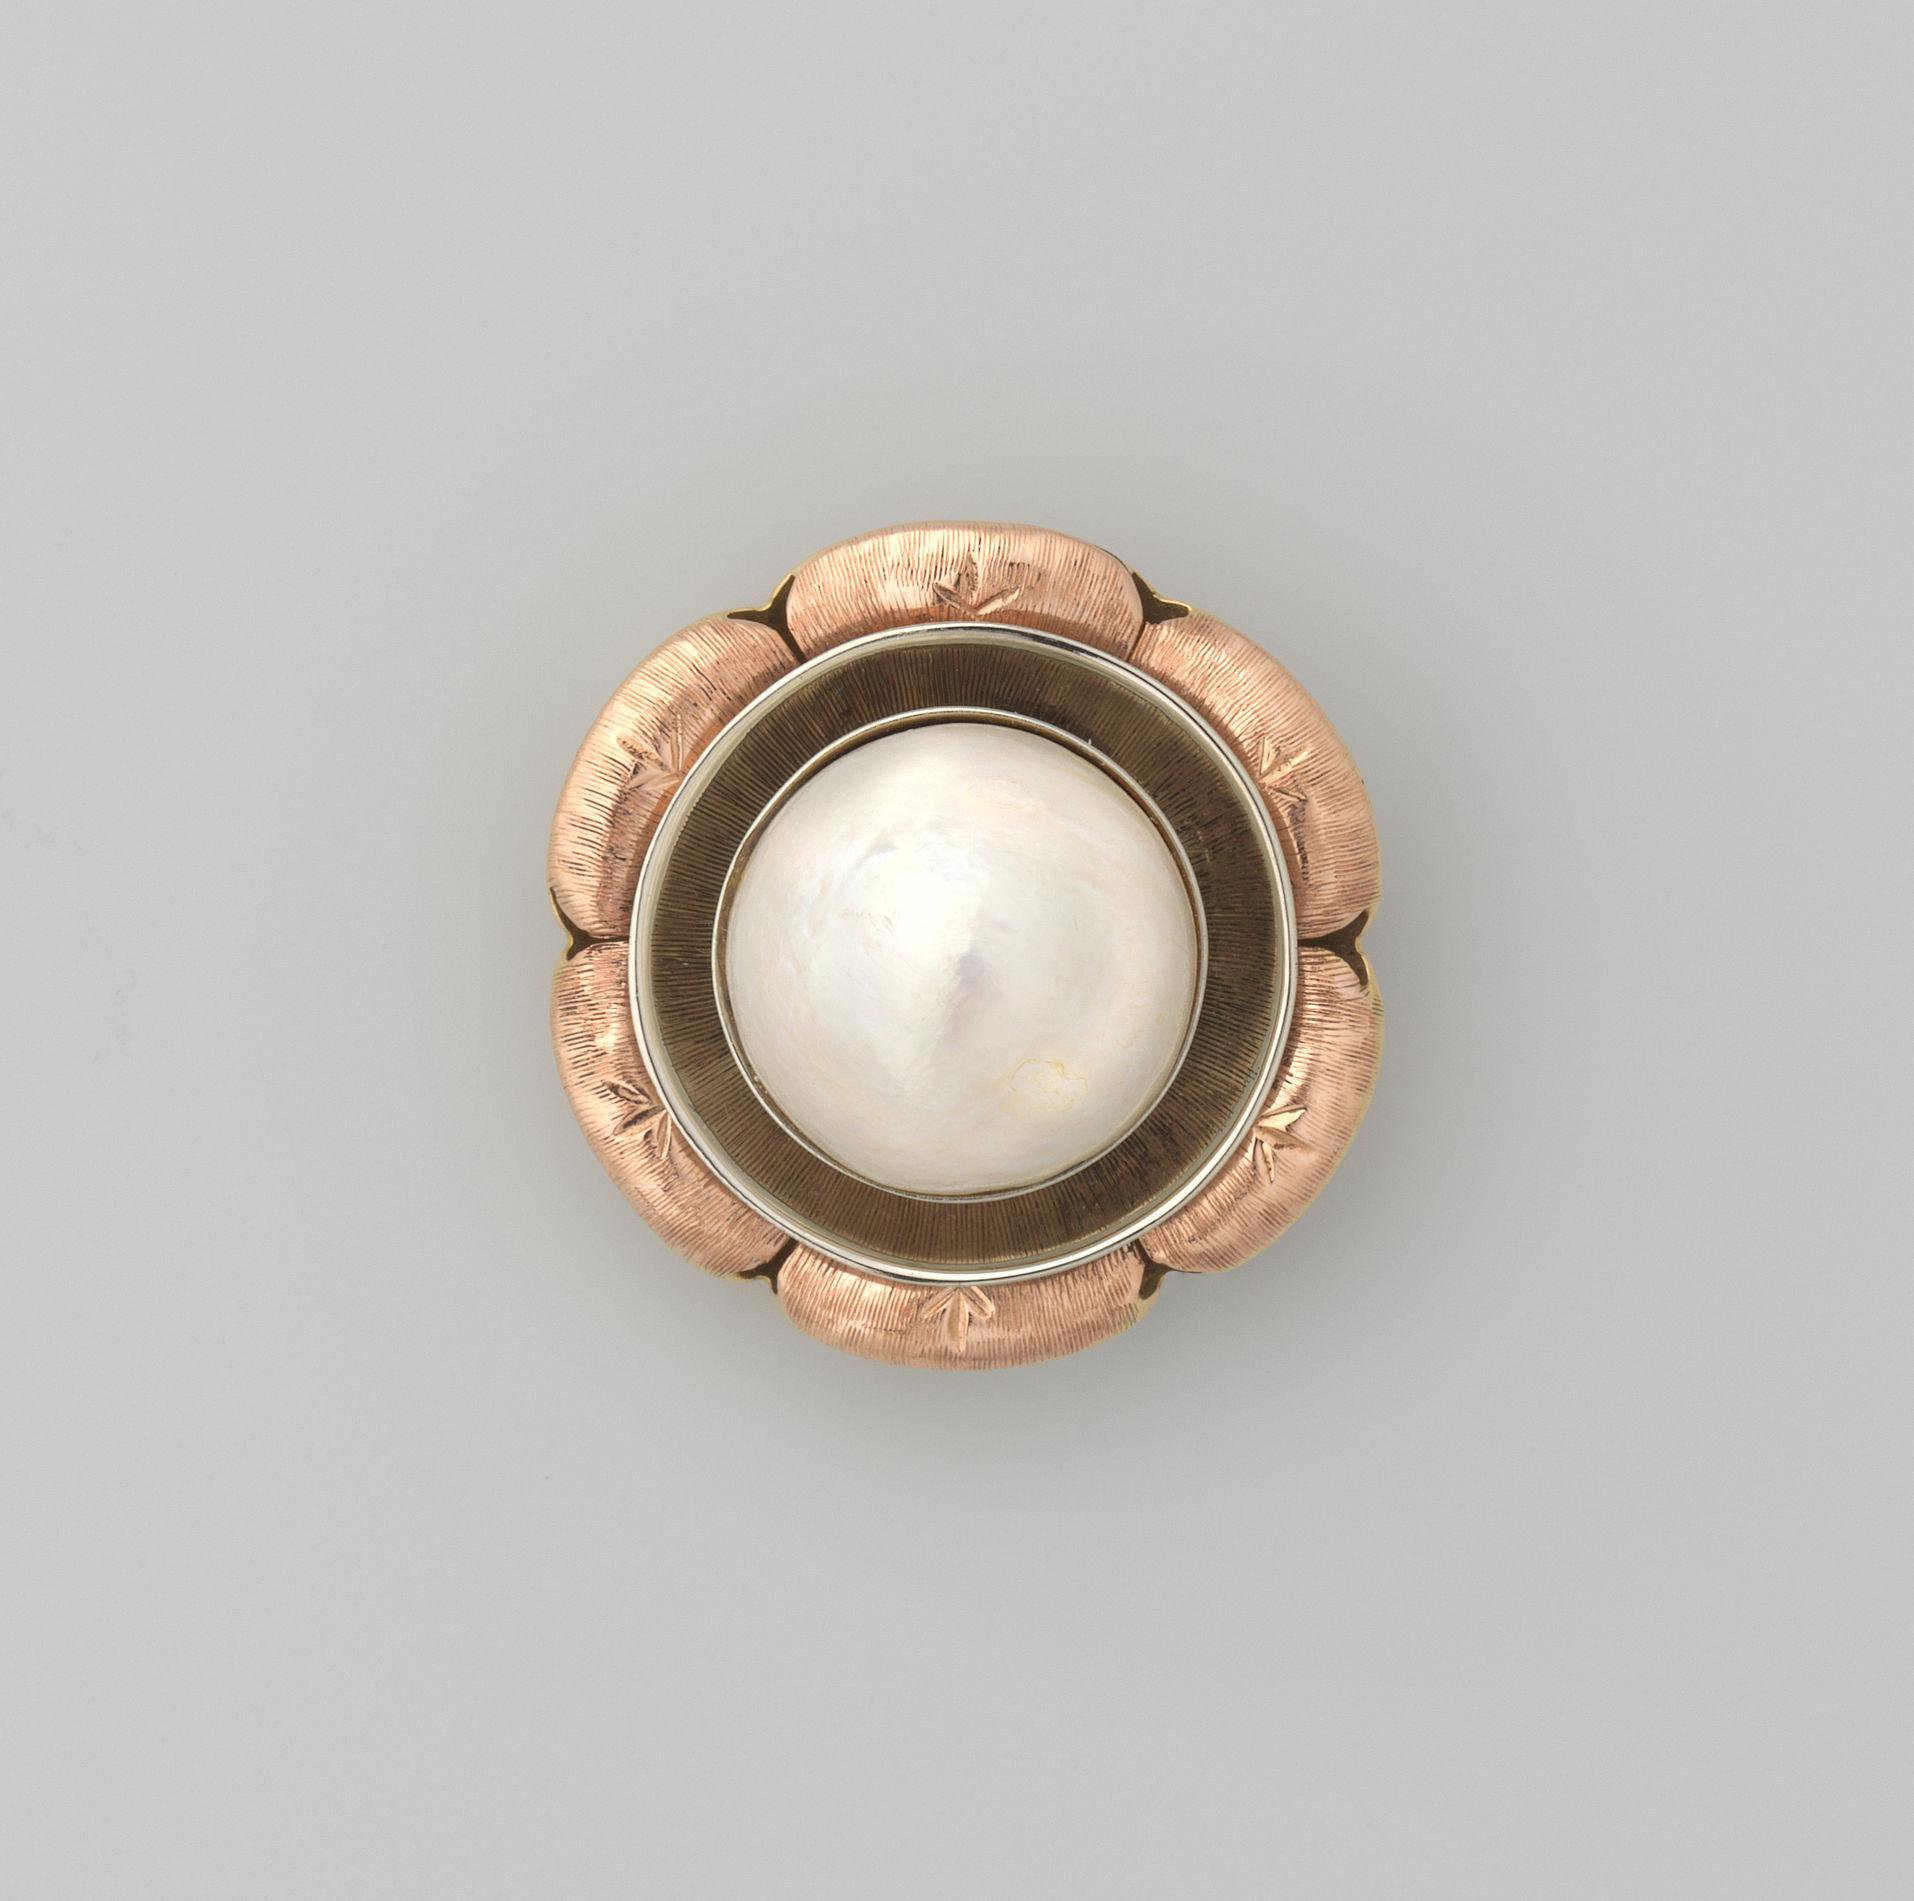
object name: brooch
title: Broche van goud met centraal een parel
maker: Anonymous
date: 1920-1930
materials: gold, pearl, silver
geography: netherlands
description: Samengestelde broche van geel en rood goud met centraal een mabe parel, voorzien van kanonsluiting. De broche is gemaakt van een ring waarvan de scheen is verwijderd en waar een brochering is aangezet. Geen verantwoordelijkheidstekens.